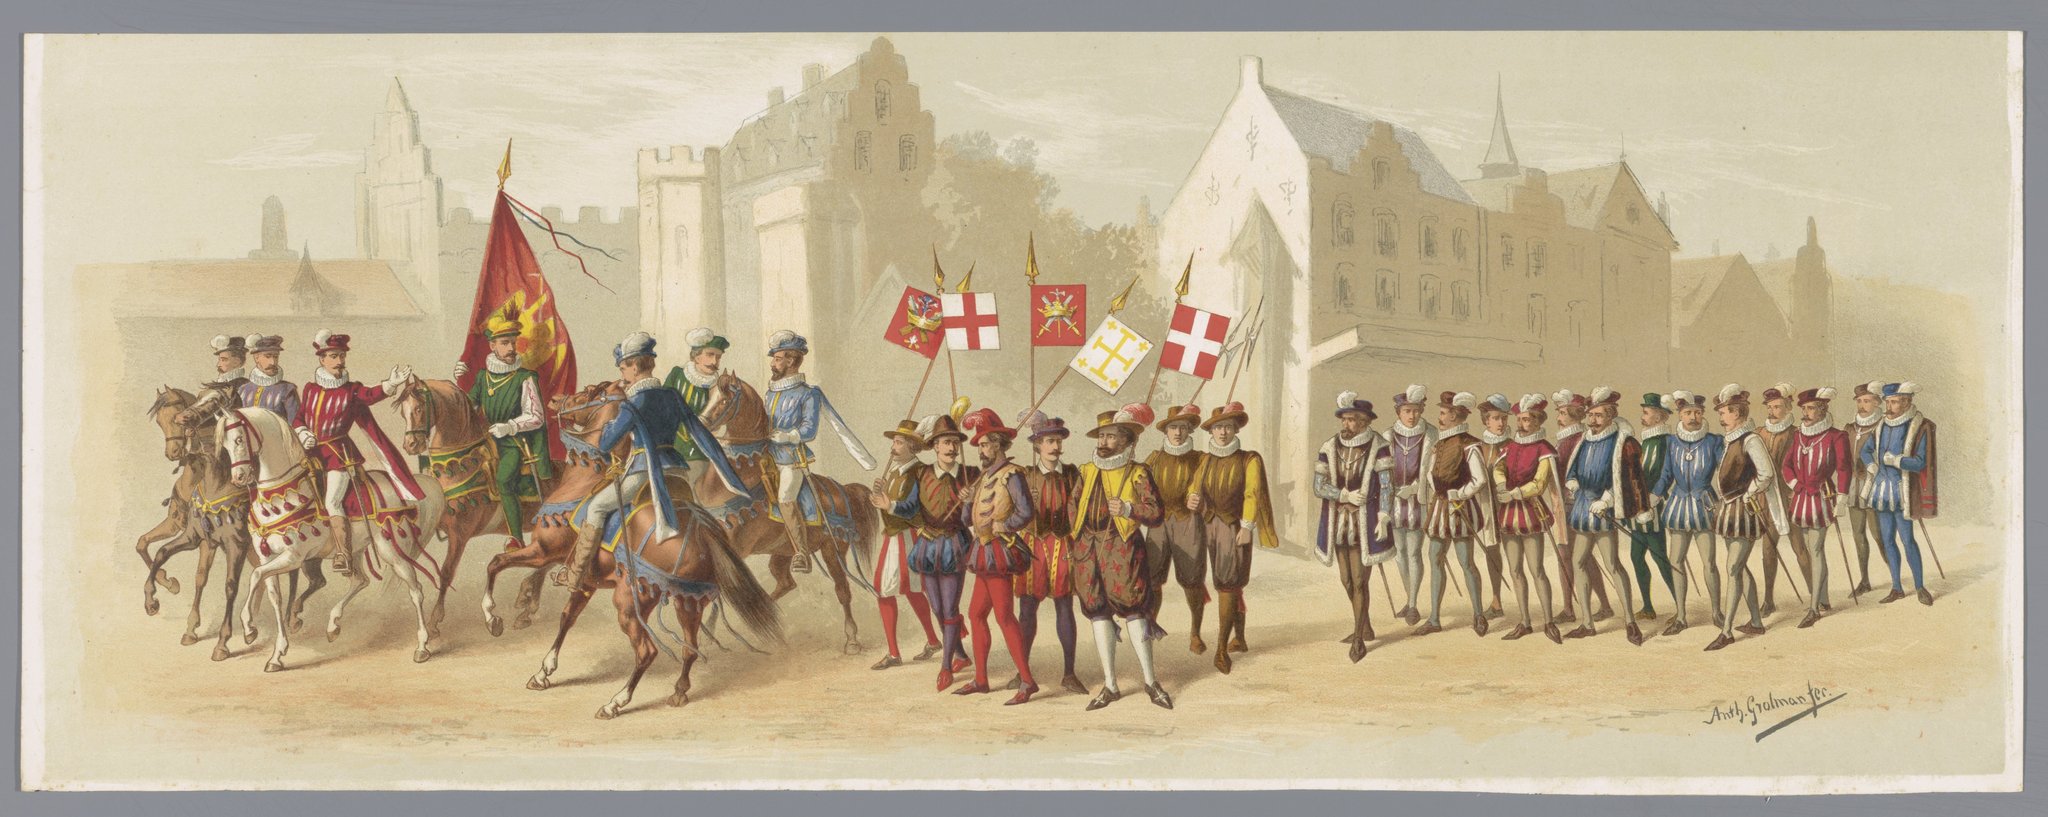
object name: print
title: Triumphelijcke Incomst vanden doorluchtighen ende hooghgheboren Aerts-hertoge Matthias, binnen die princelijcke stadt van Brussele in t'iaer ons heeren M.D.LXXVIII. den xviij dach Januarij. Gehouden door Heeren Leden van het Utrechtsche Studentencorps op den 28 Juni 1881 bij gelegenheid van het 245-jarig bestaan der Hoogeschool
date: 1881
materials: paper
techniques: chromolithography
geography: utrecht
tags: matthias van oostenrijk (rooms-duits keizer), students' pageant, costumes used in pageants, commemoration of the founding of a university, utrecht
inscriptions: collector's mark: Lugt 2228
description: Tweede plaat met een deel van de optocht. Onderdeel van de serie van zeven platen plus titelprent en verklaring van de gekostumeerde optocht door de studenten van de Utrechtse Hogeschool op 28 juni 1881 bij de viering van het 245-jarig bestaan van de Hogeschool. Voorgesteld is de intocht van aartshertog Matthias in Brusssel op 18 januari 1578.